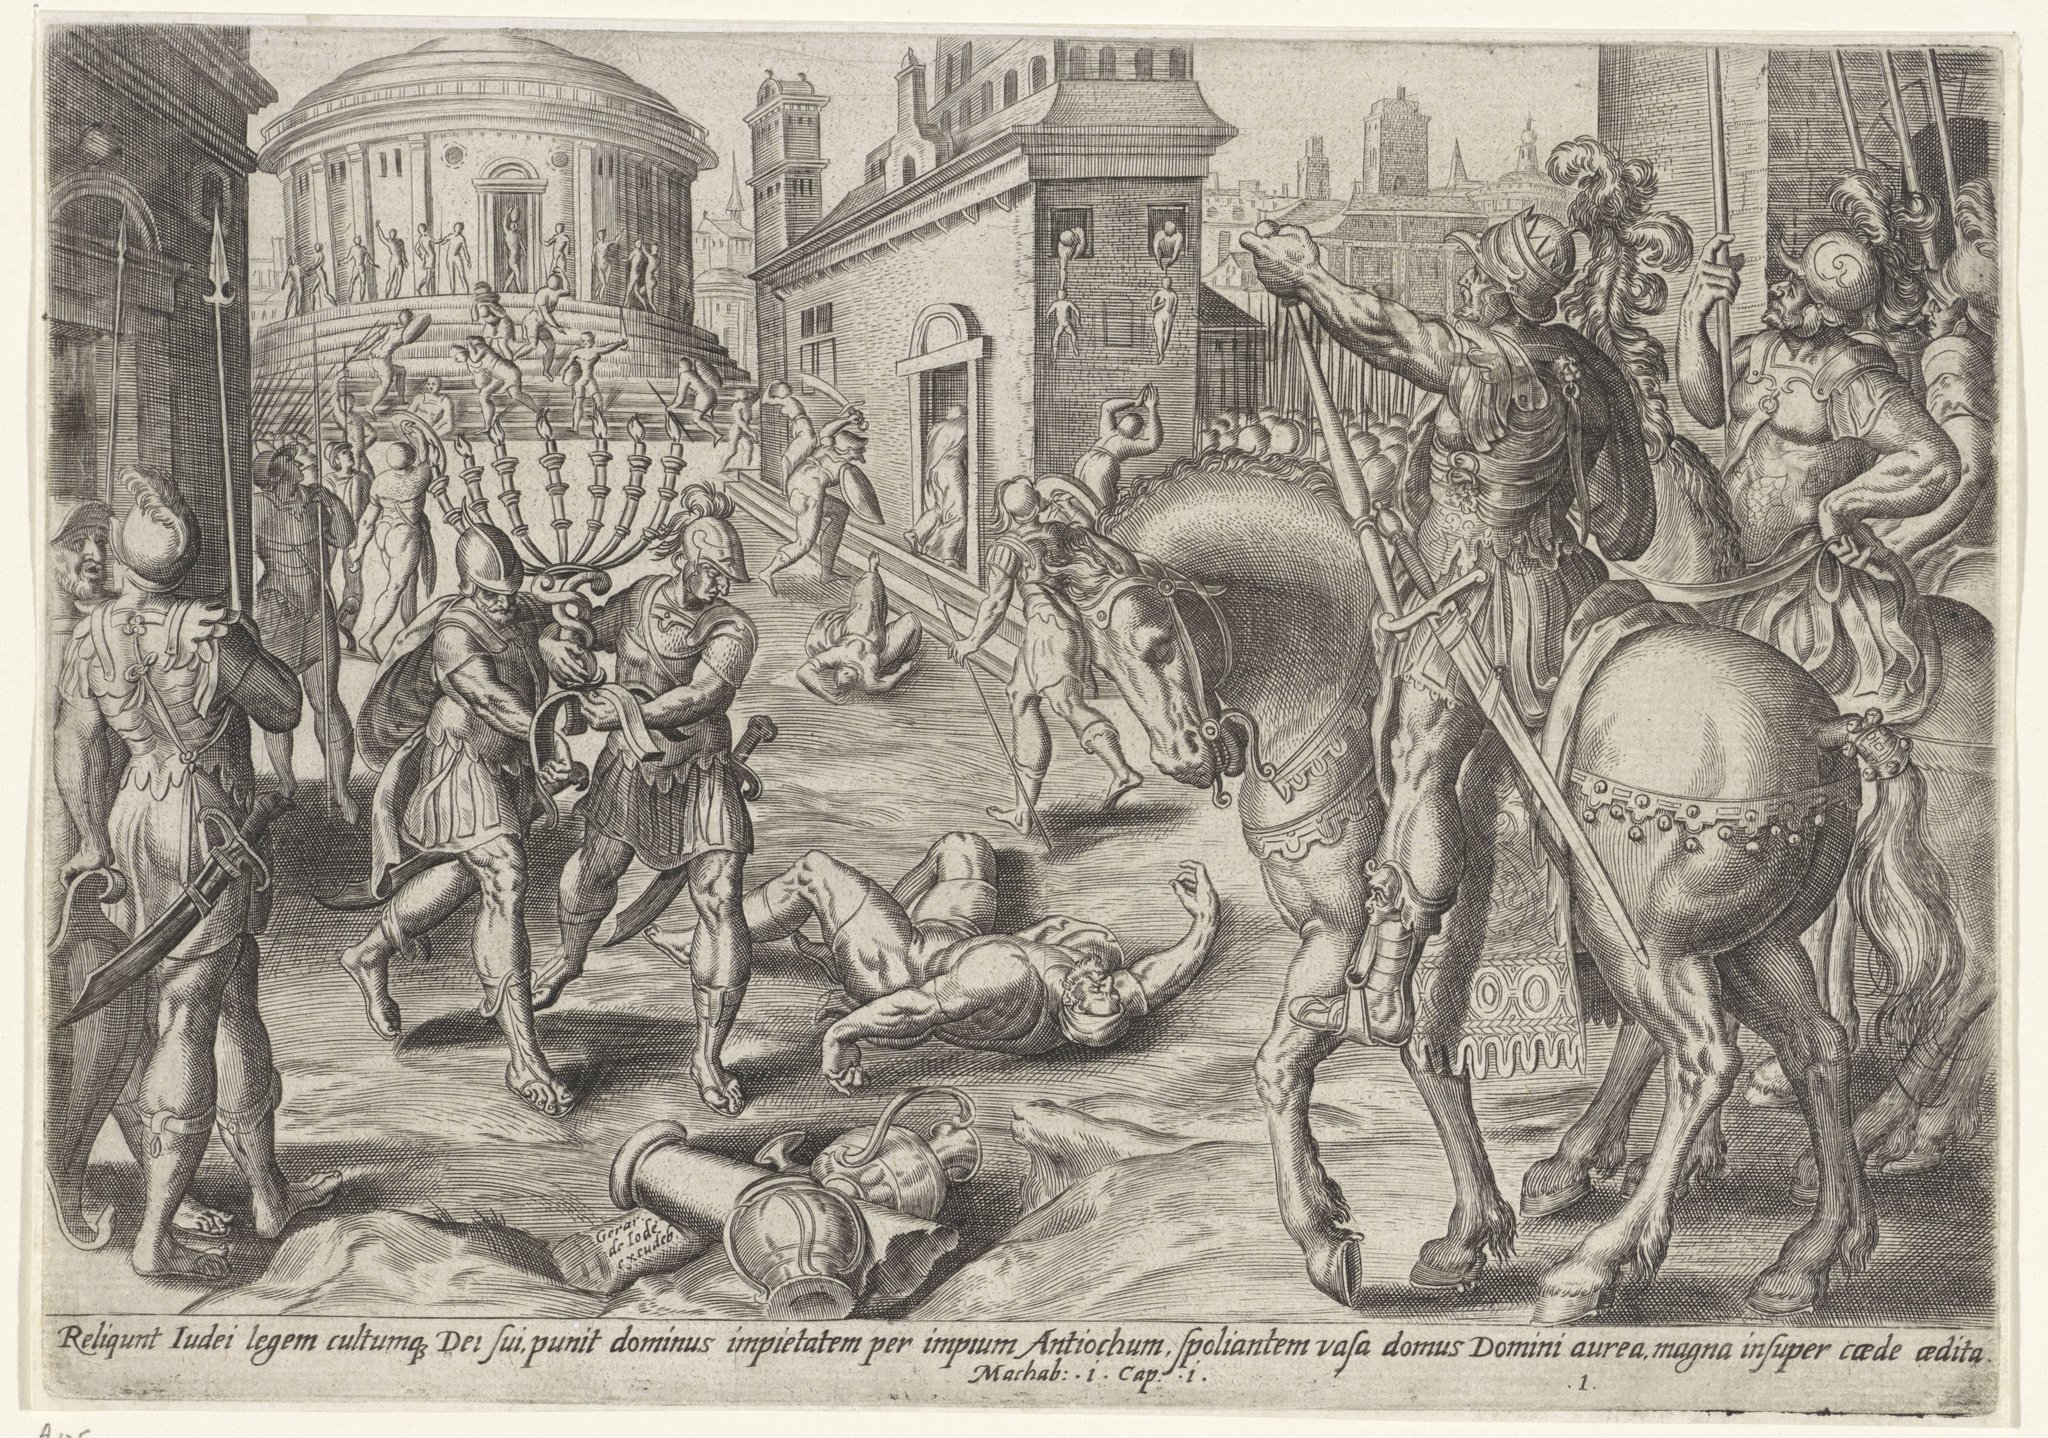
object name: print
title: Thesaurus sacrarum historiarum veteris testamenti (...)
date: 1579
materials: paper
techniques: engraving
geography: antwerp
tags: antiochus iv epiphanes robbing the temple of its treasures (1 maccabees 1:21-23)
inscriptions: collector's mark: Lugt 2228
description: Na zijn overwinning op Egypte trekt Antiochus met een groot leger naar Jeruzalem. Daar rooft hij de tempel leeg en richt hij een bloedbad aan onder de inwoners. Onder de voorstelling een verwijzing in het Latijn naar de Bijbeltekst in 1 Makk. 1.